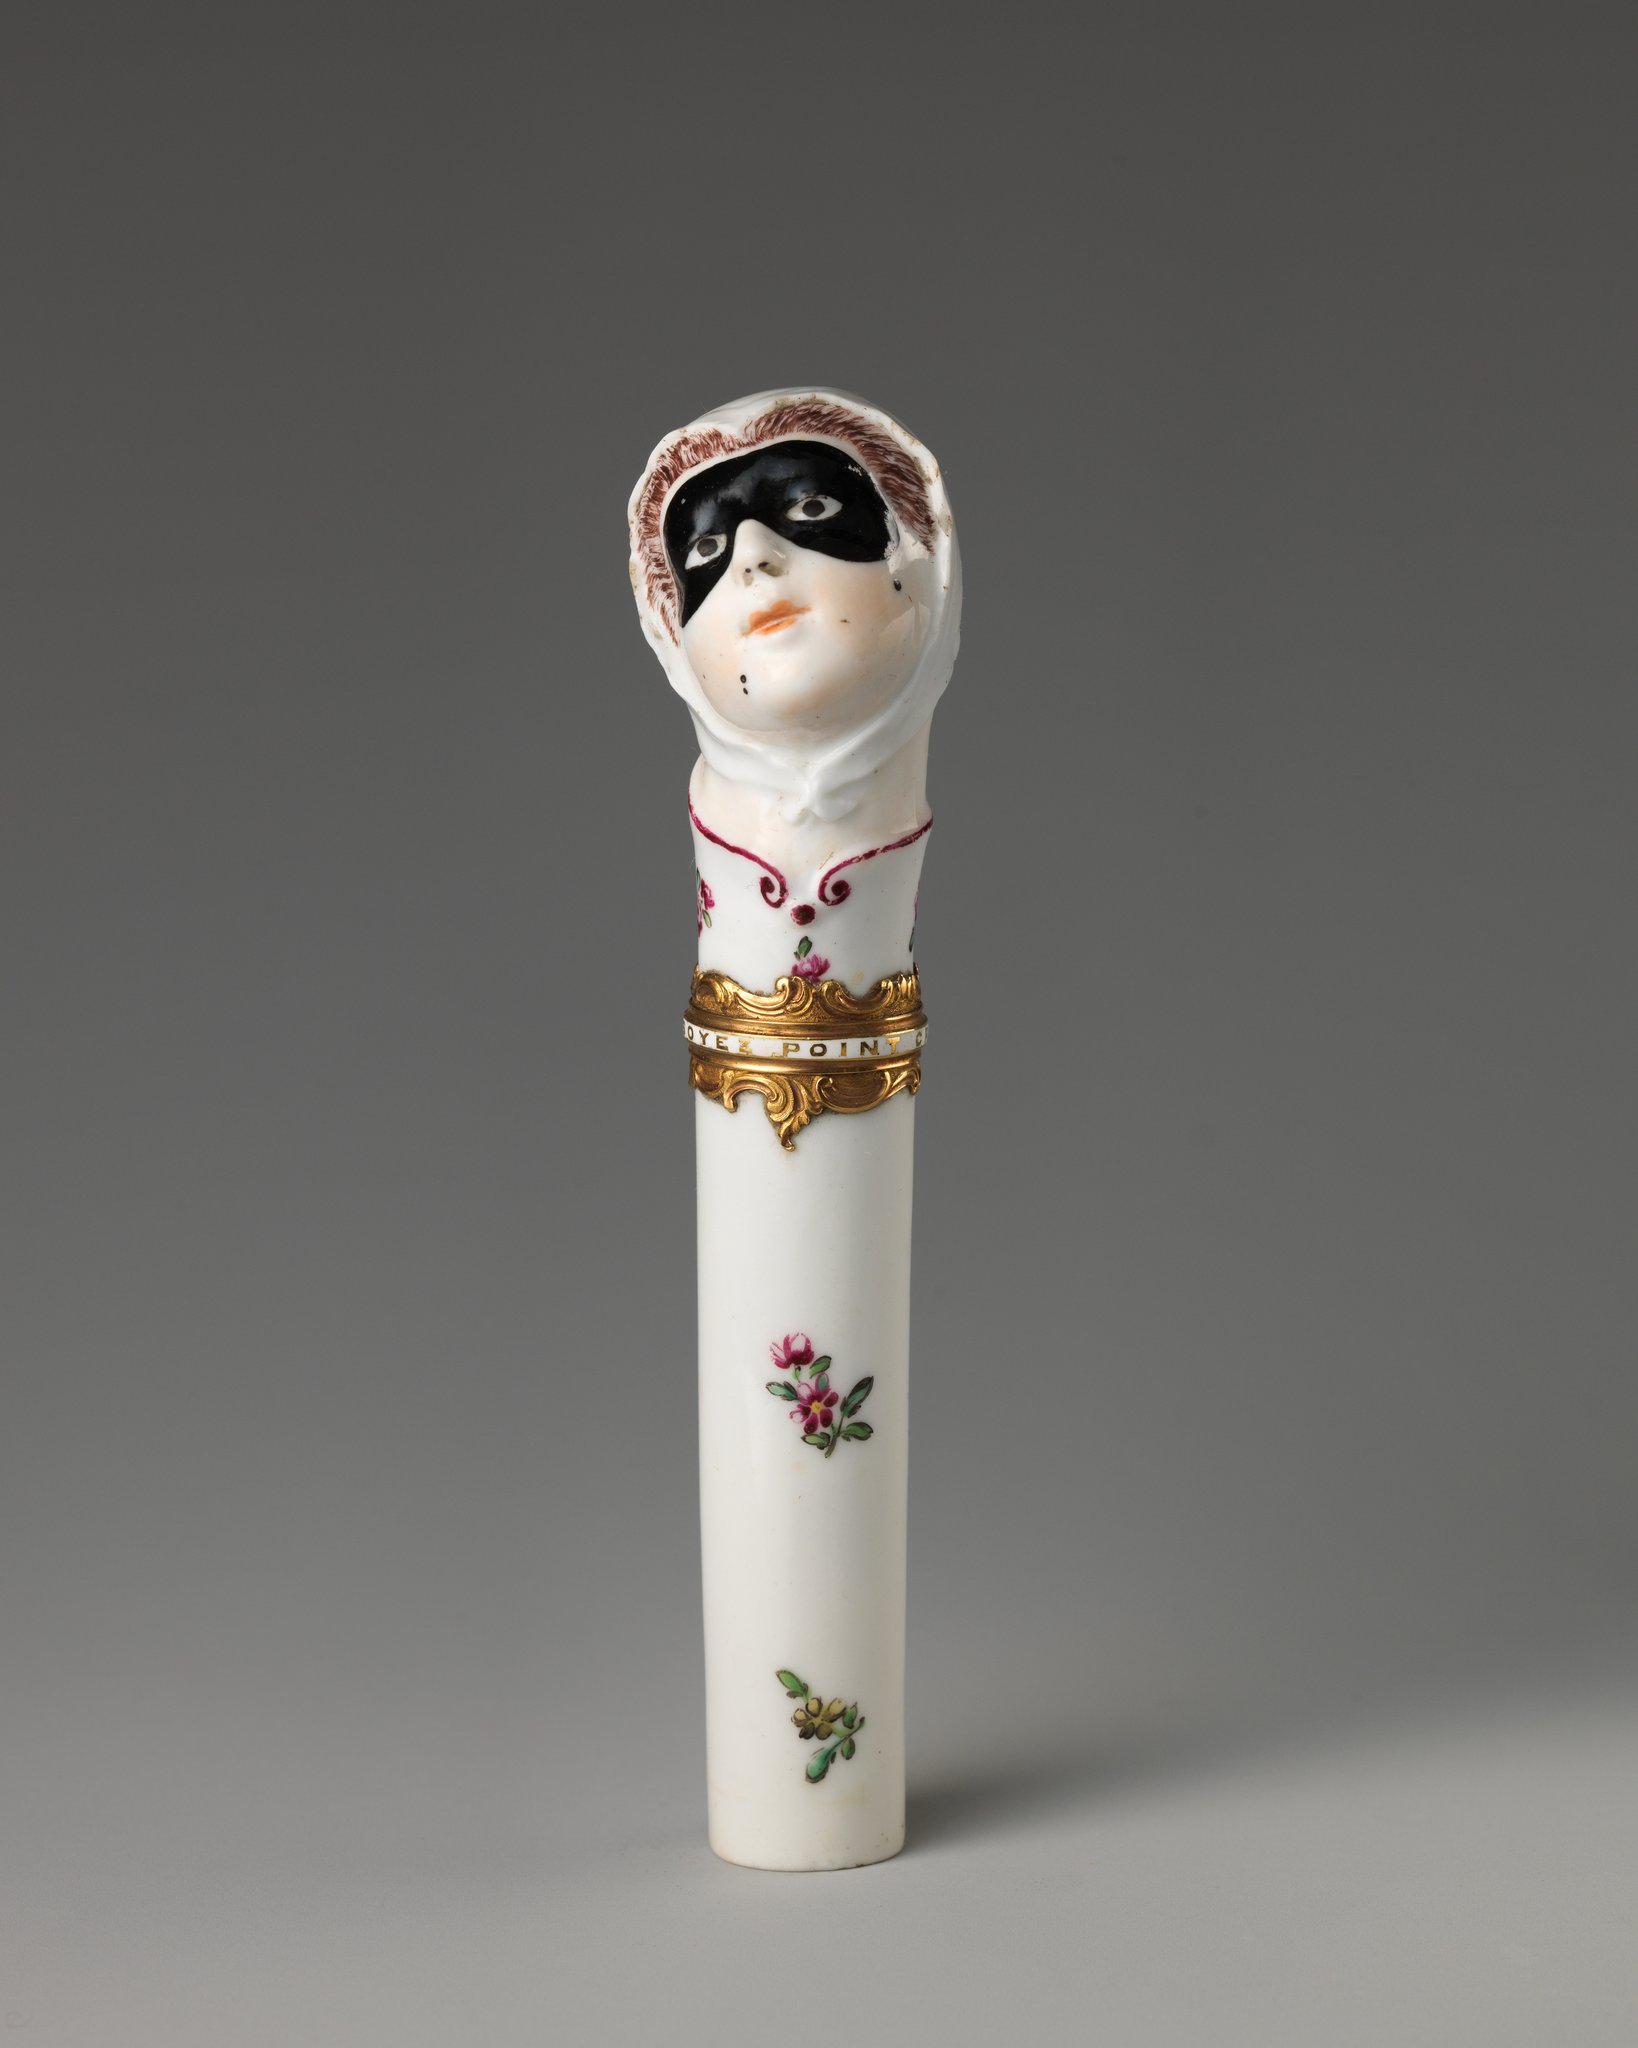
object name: toy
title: Head of Columbine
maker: saint james's factory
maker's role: maker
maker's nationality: british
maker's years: 1749-1759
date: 1750-1755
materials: soft paste porcelain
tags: heads,flowers